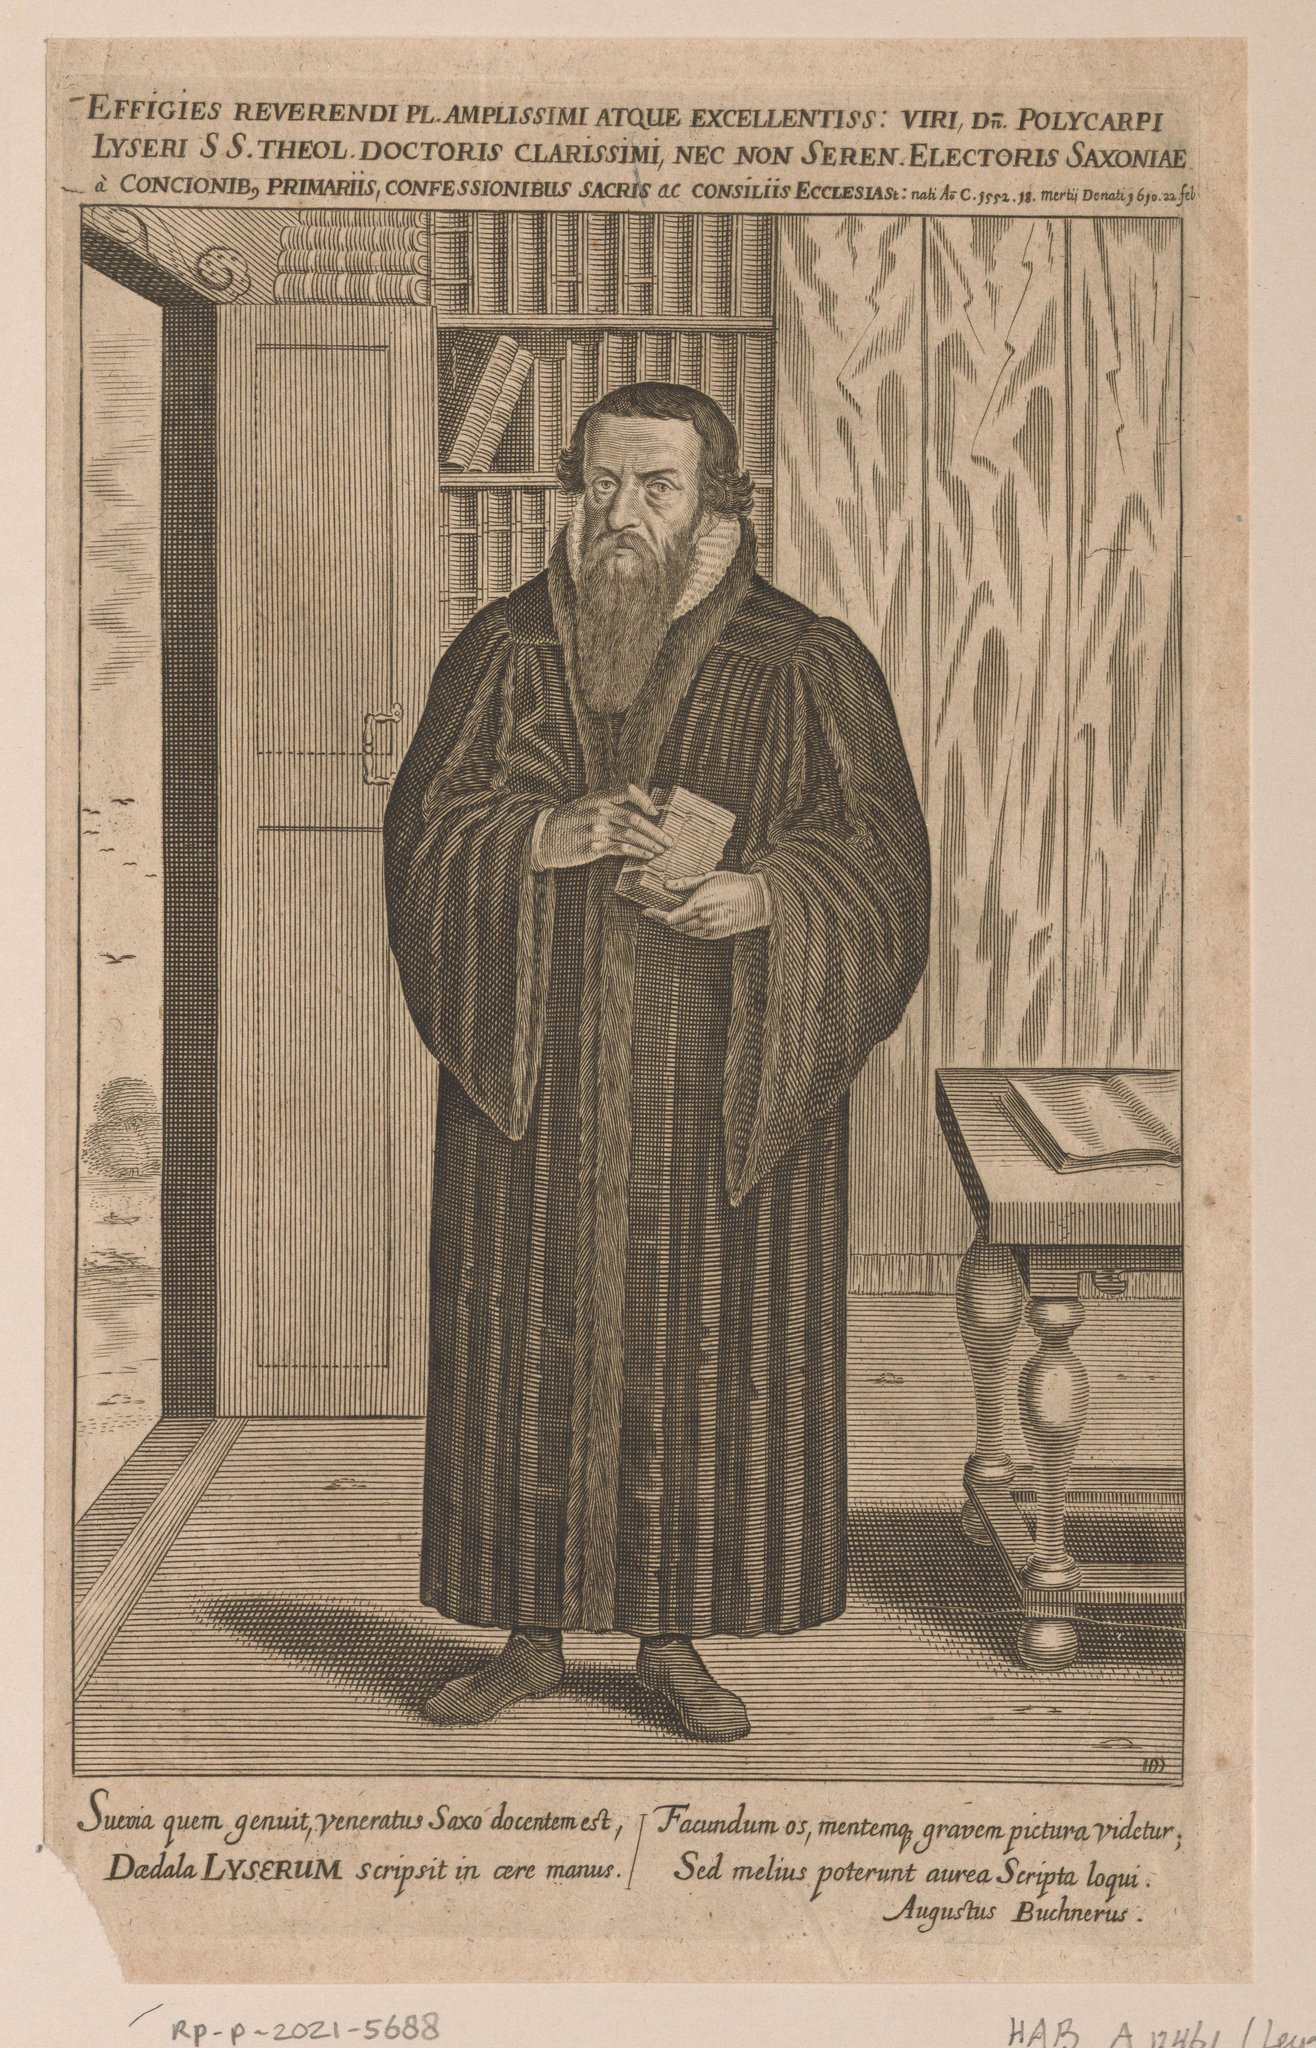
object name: print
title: Portret van Polykarp Leyser I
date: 1652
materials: paper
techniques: engraving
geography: germany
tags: bookshelves, theologian, historical persons, book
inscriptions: monogram: ‘DD’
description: Prent is met tekst in boekdruk op verso gebruikt in: Chemnitz, Martin, Polycarp Leyser en Johann Gerhard. Harmonia quatuor Evangelistarum. Frankfurt am Main en Hamburg: Zacharias Hertel, 1652, dl. 1.